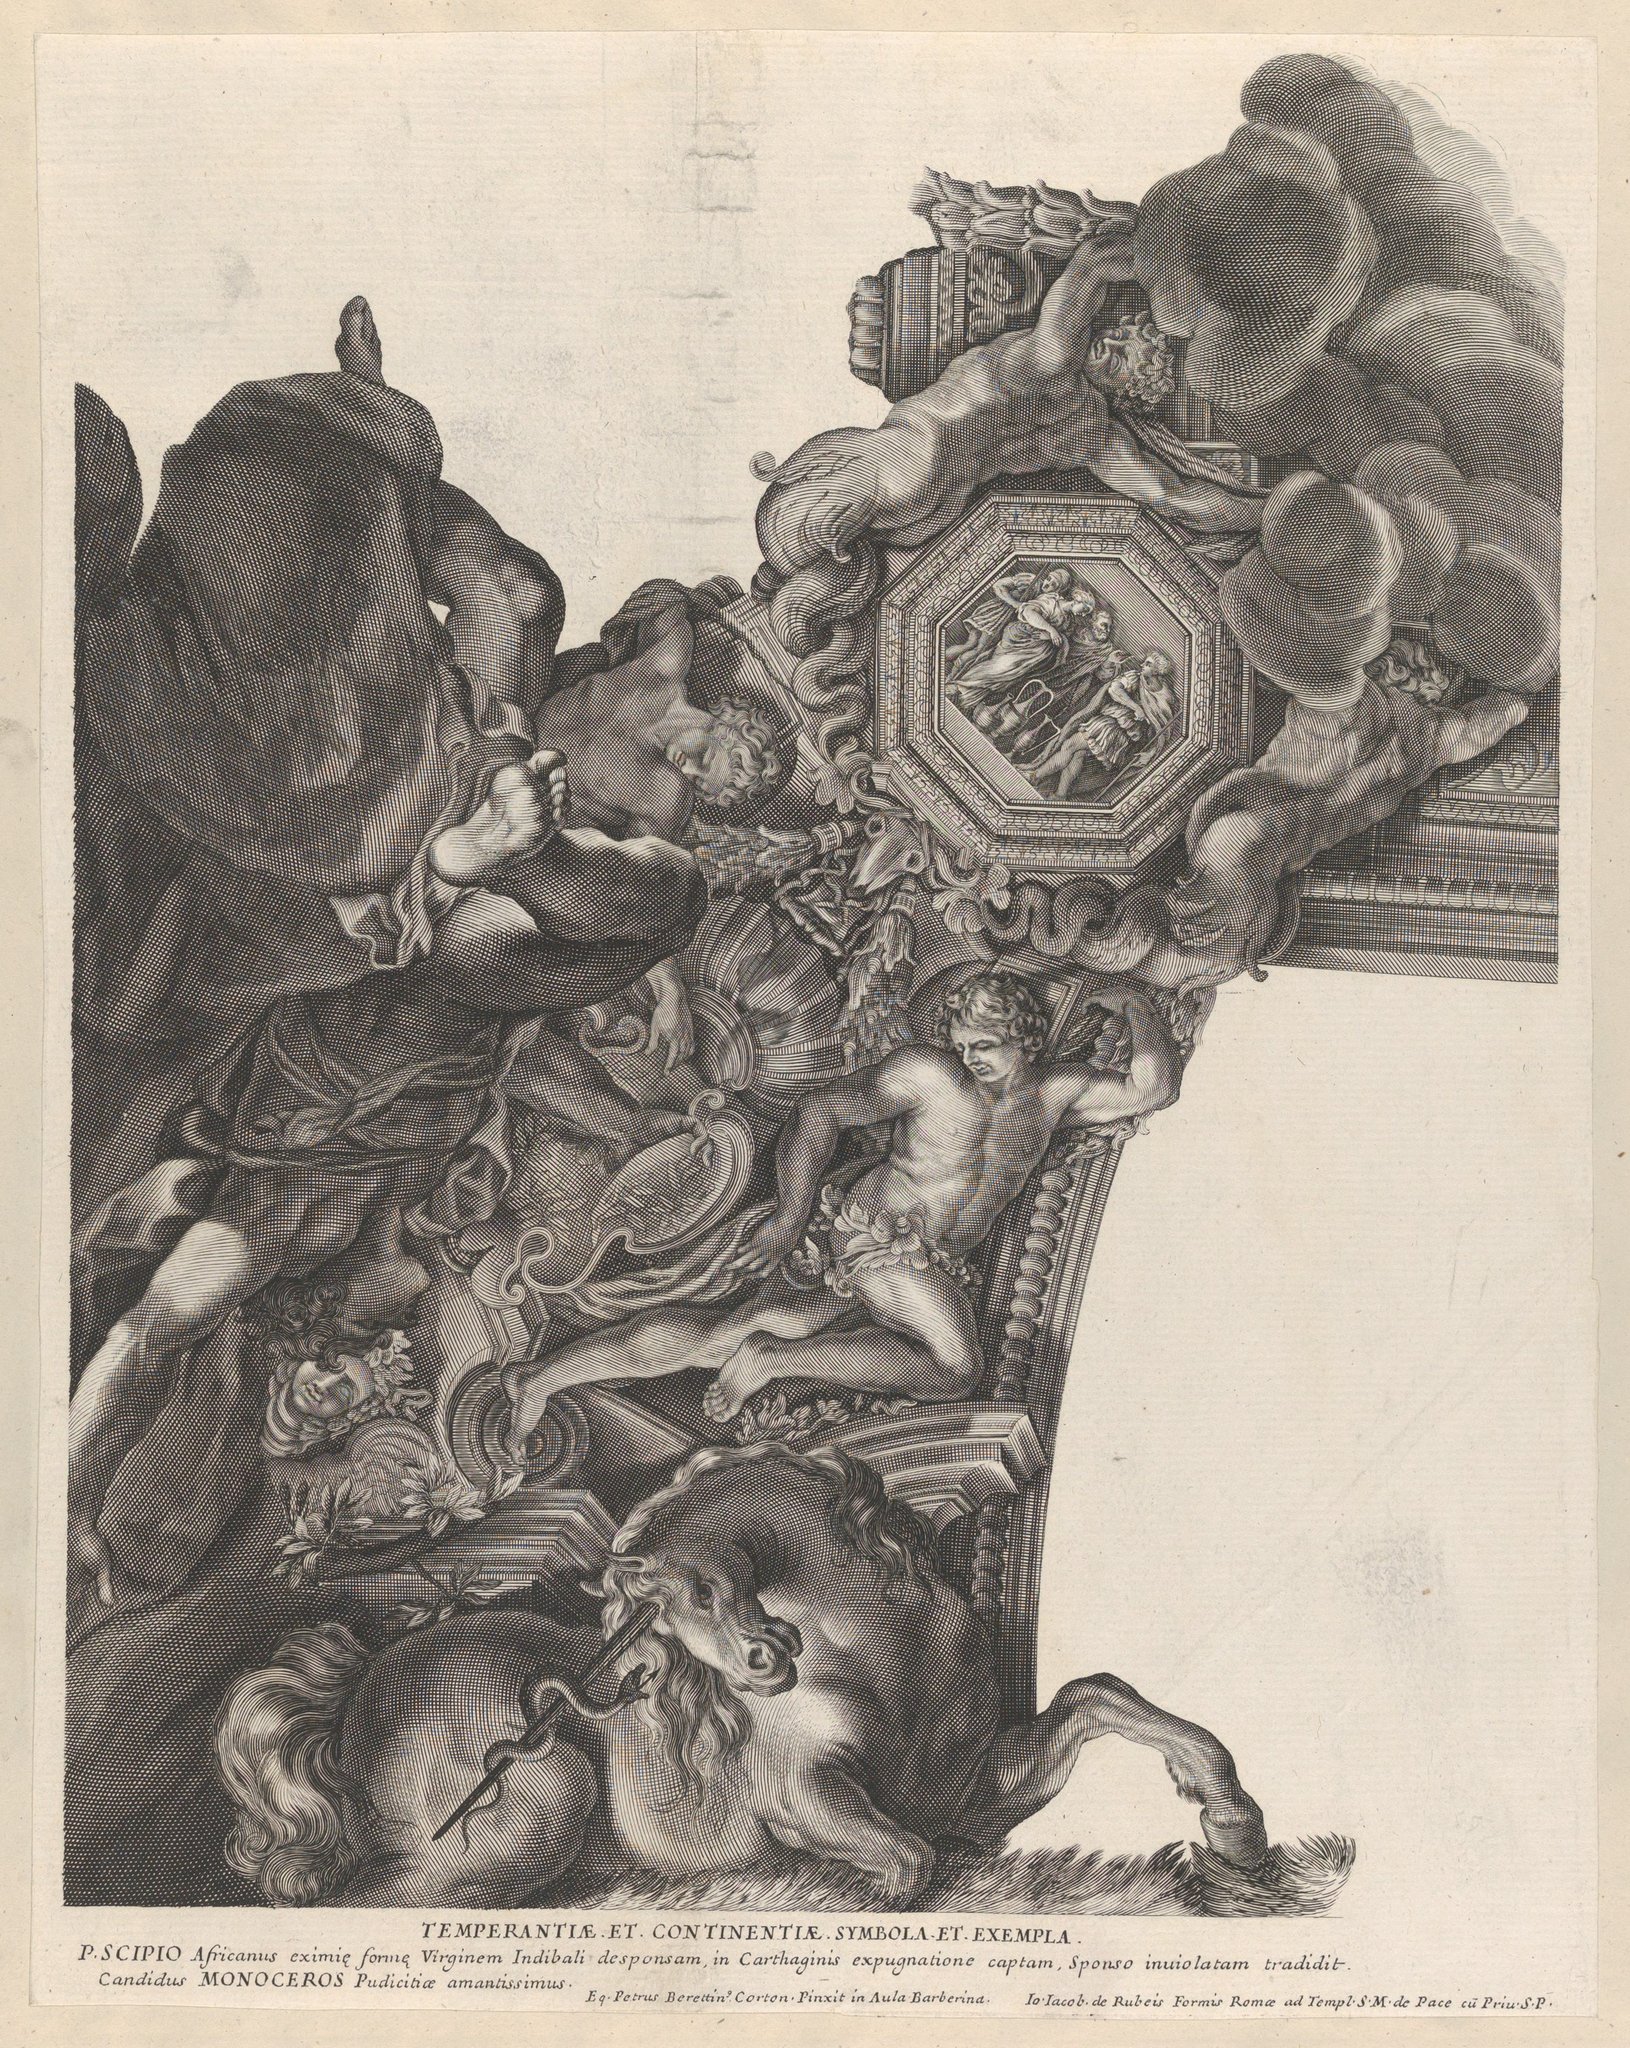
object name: print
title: Plate 9: Allegory of Temperance with a unicorn and Publius Scipio Africanus at bottom, from "Barberinae aulae fornix"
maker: anonymous, italian, 17th century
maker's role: artist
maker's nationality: italian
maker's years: 1600-1700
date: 1677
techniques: engraving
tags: men,unicorns